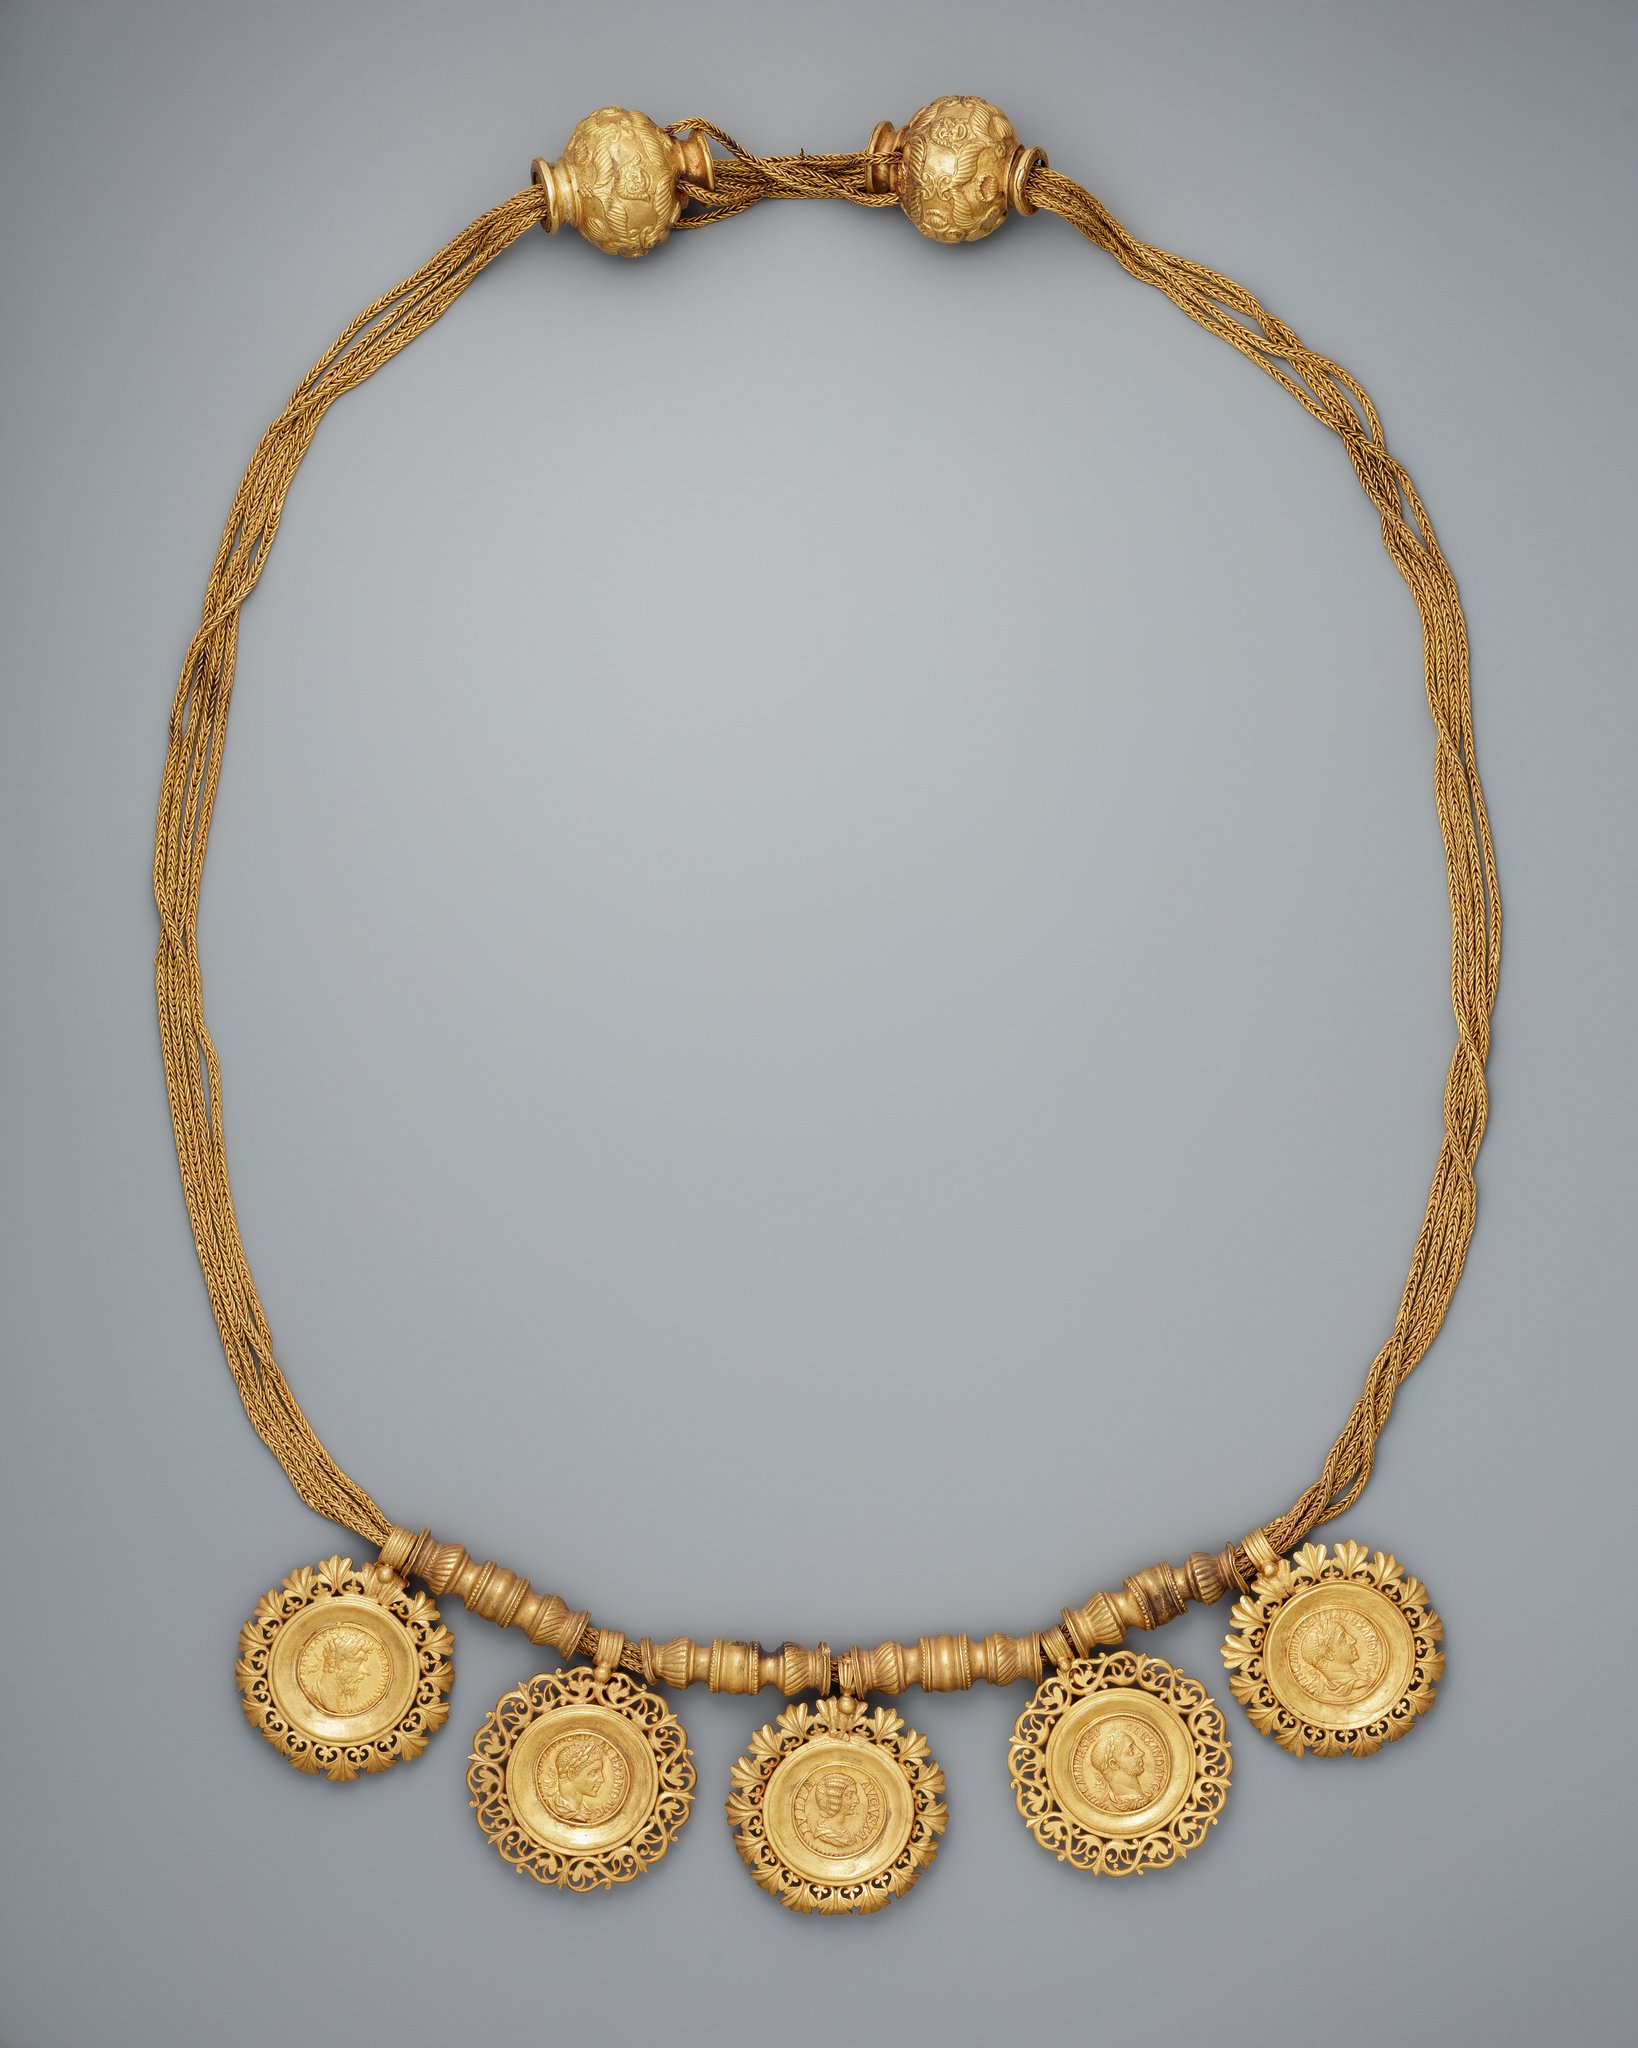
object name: necklace, with medallion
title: Collar with medallions containing coins of emperors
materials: gold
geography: memphite region